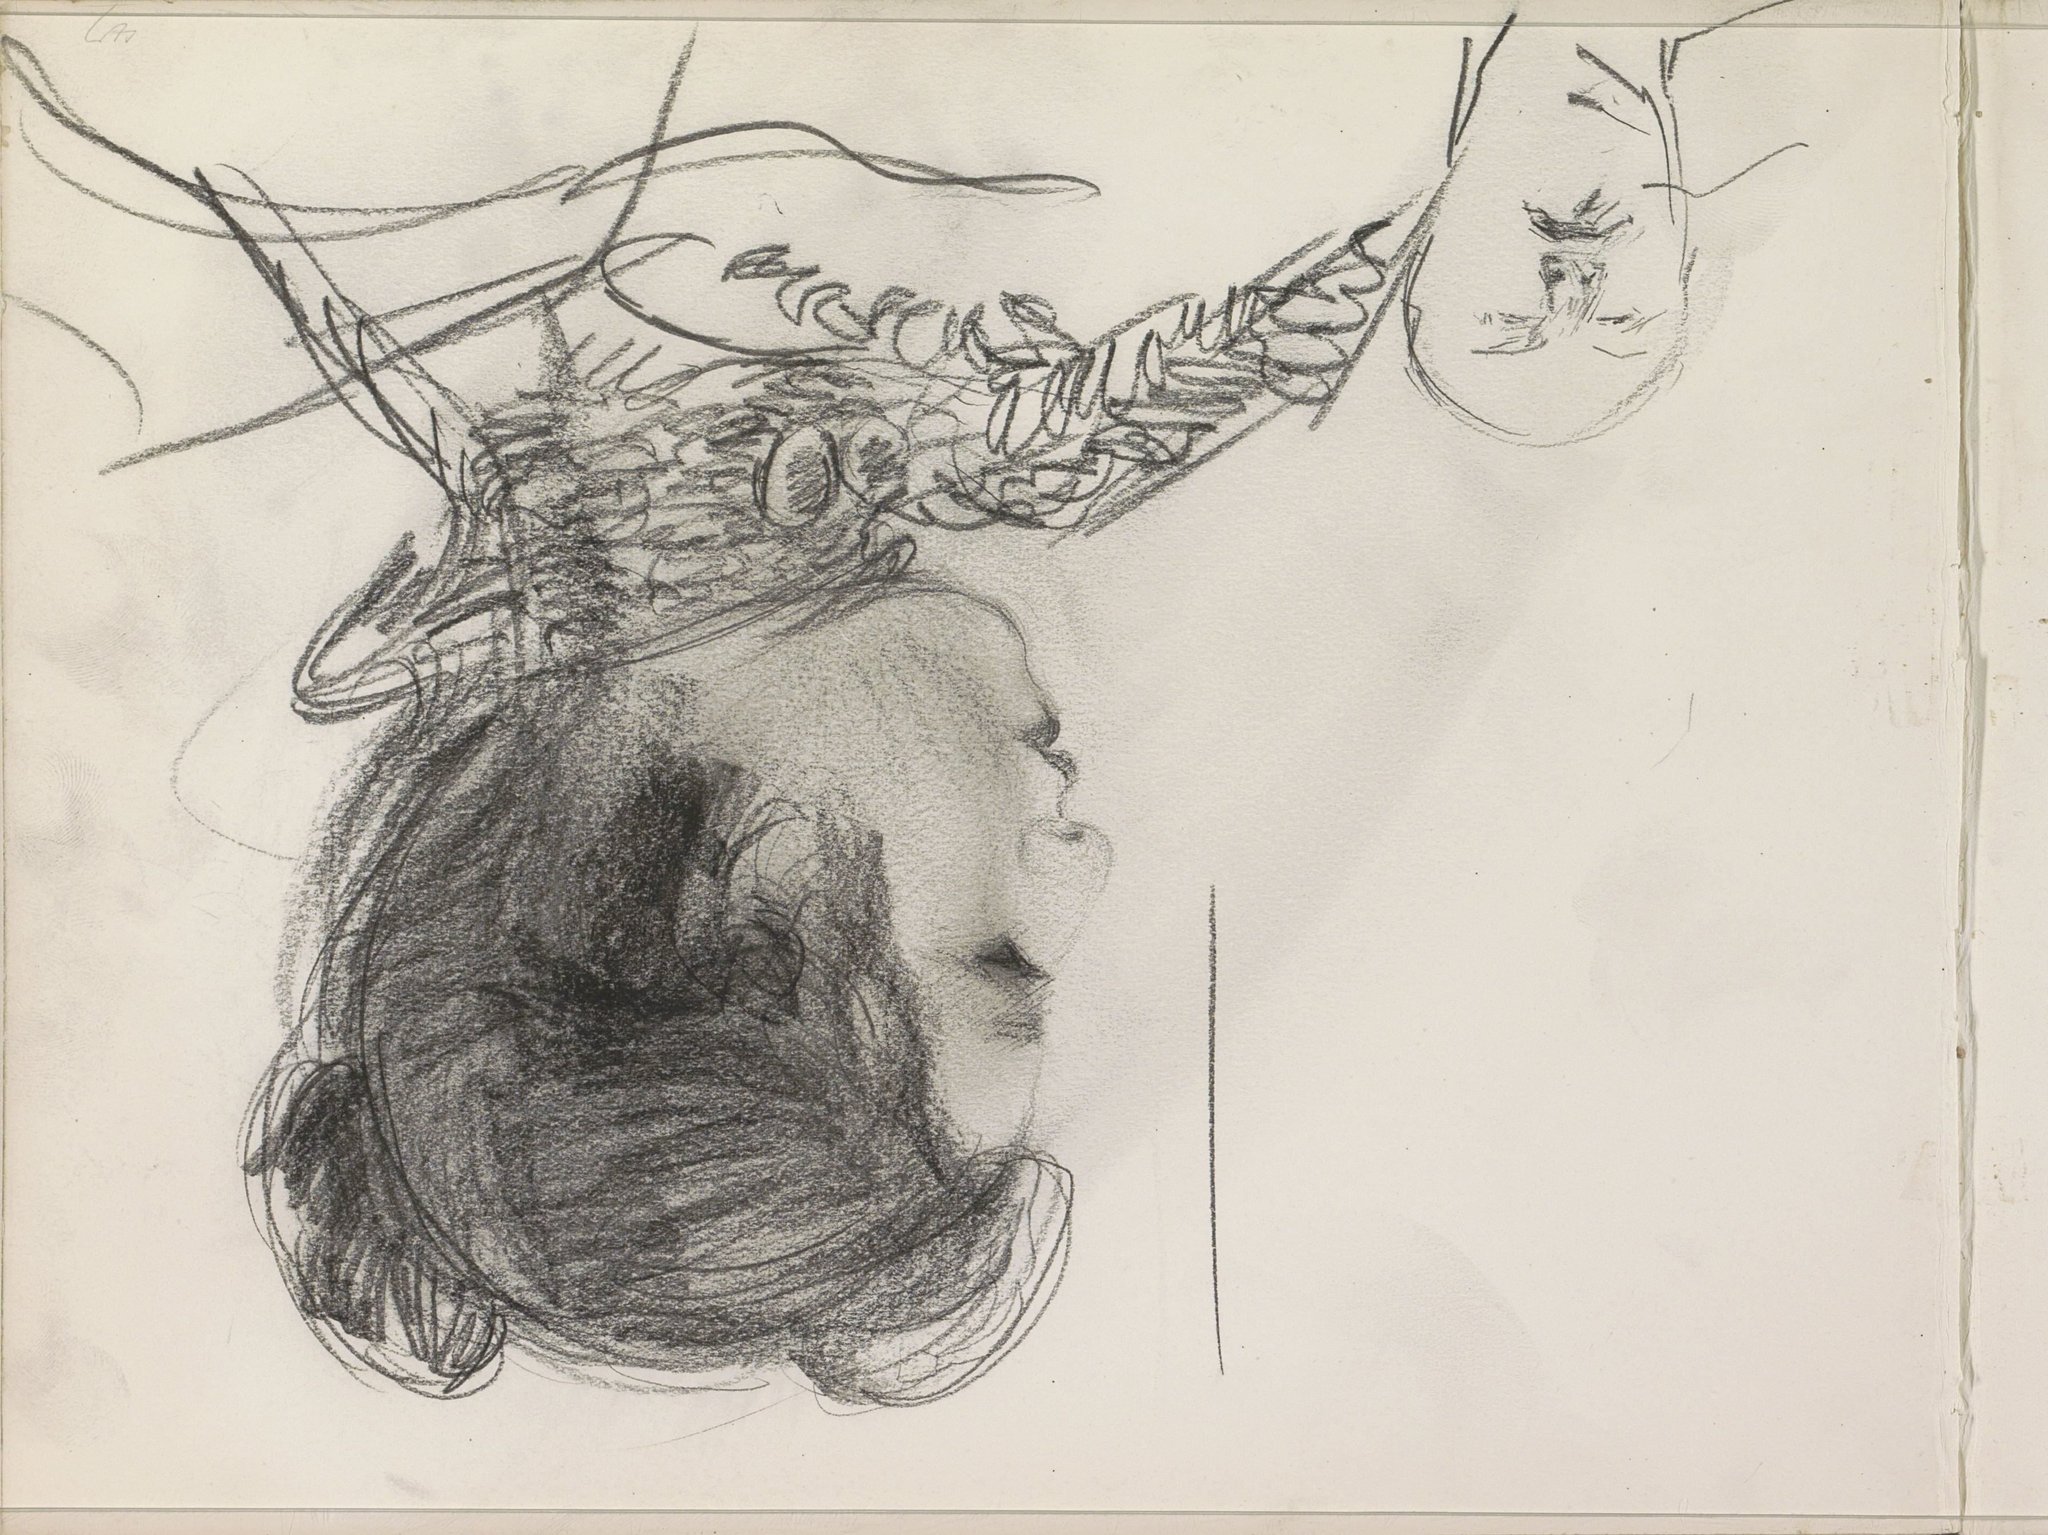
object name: sketchbook leaf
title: Vrouwenhoofd, in profiel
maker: isaac israels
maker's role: draughtsman, painter, print maker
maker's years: 1865-1934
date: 1875-1934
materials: chalk, paper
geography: the hague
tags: head (human) - aa - female human figure (+ sideview, profile)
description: Boven een tweede studie van een hoofd. Blad 6 verso uit schetsboek VII met 26 bladen.